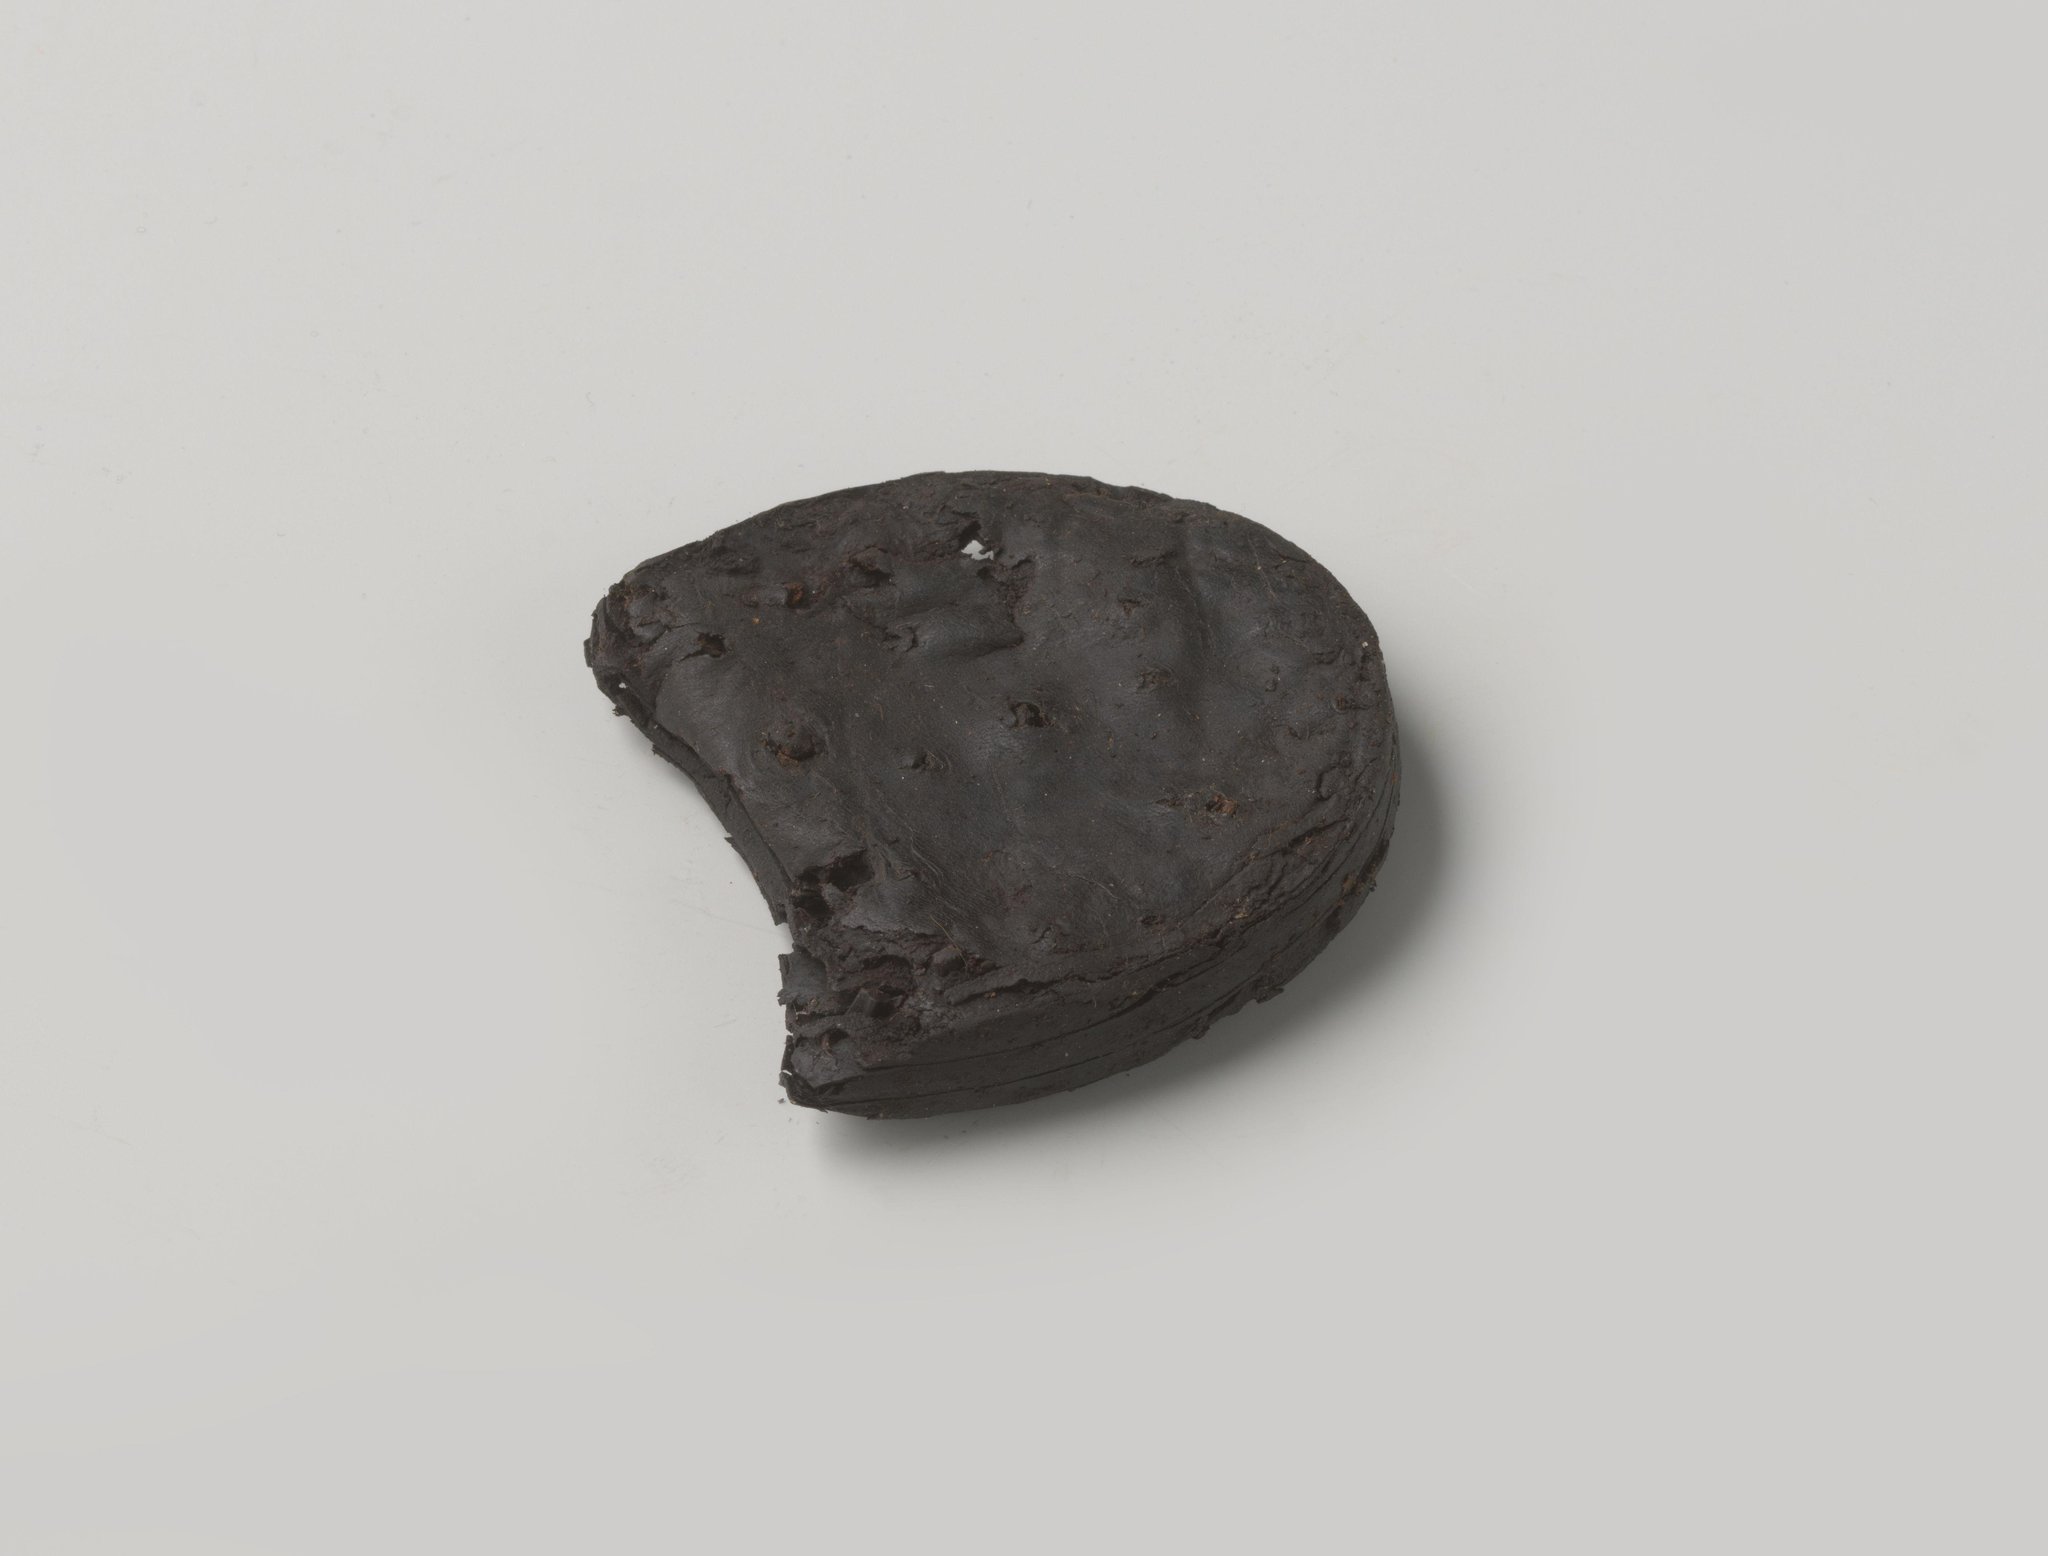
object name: fragment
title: Hak van een schoen uit het wrak van de Oostindiëvaarder Hollandia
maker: Anonymous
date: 1700-1743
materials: leather, wood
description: Hak van een schoen, opgebouwd uit lagen leer met houten pennen.